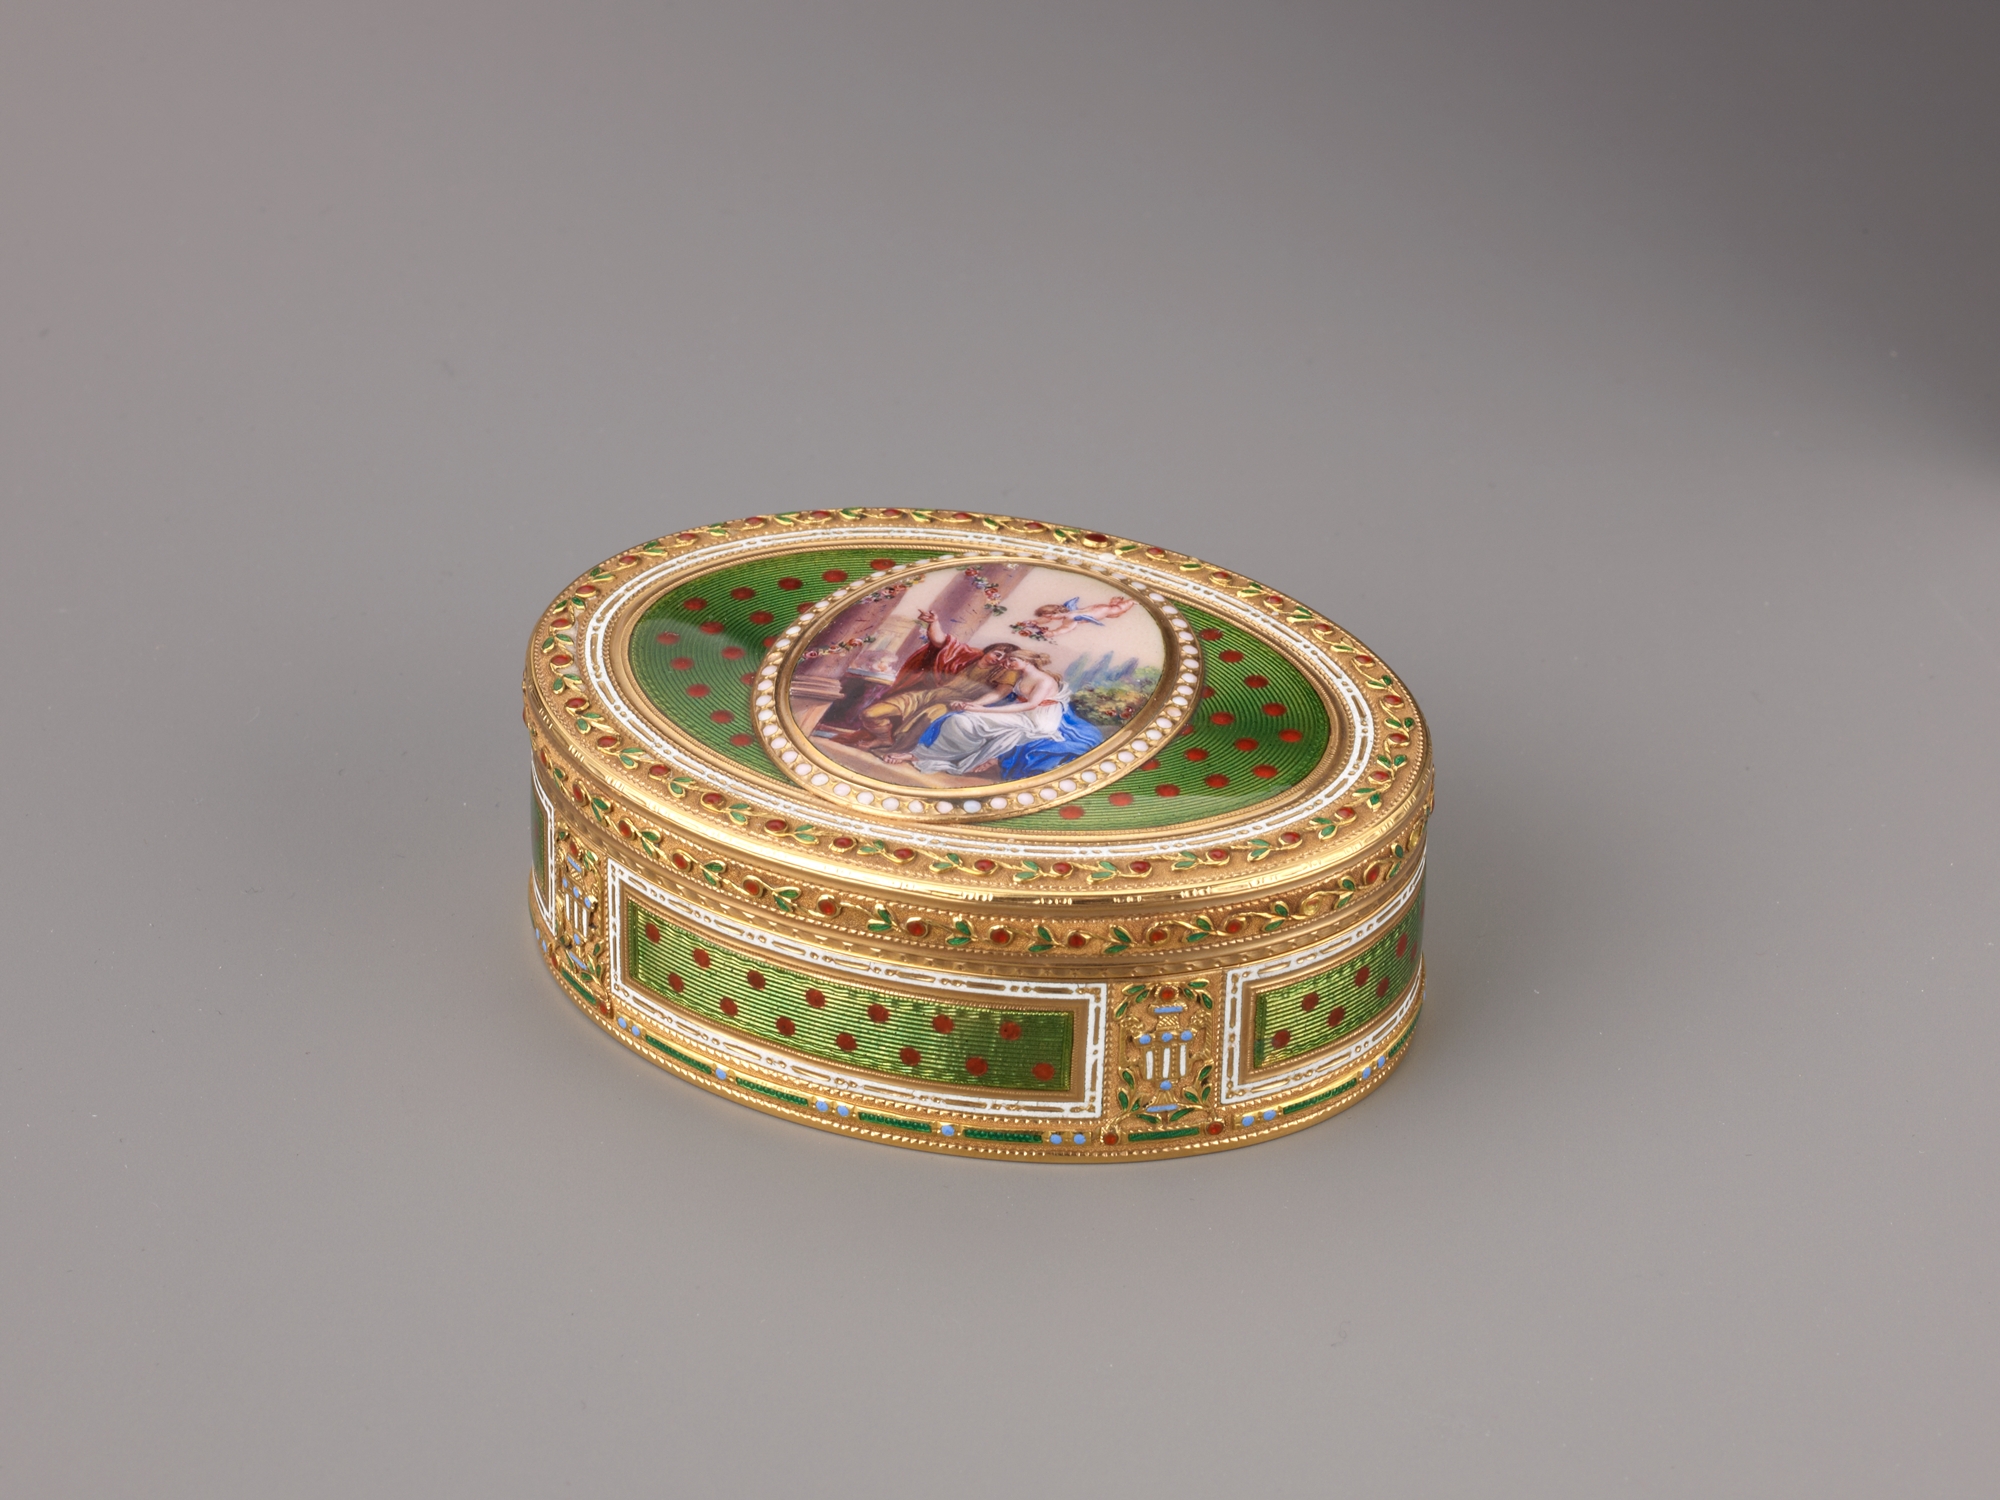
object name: snuffbox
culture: swiss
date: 1785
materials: enamel, gold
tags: men,women